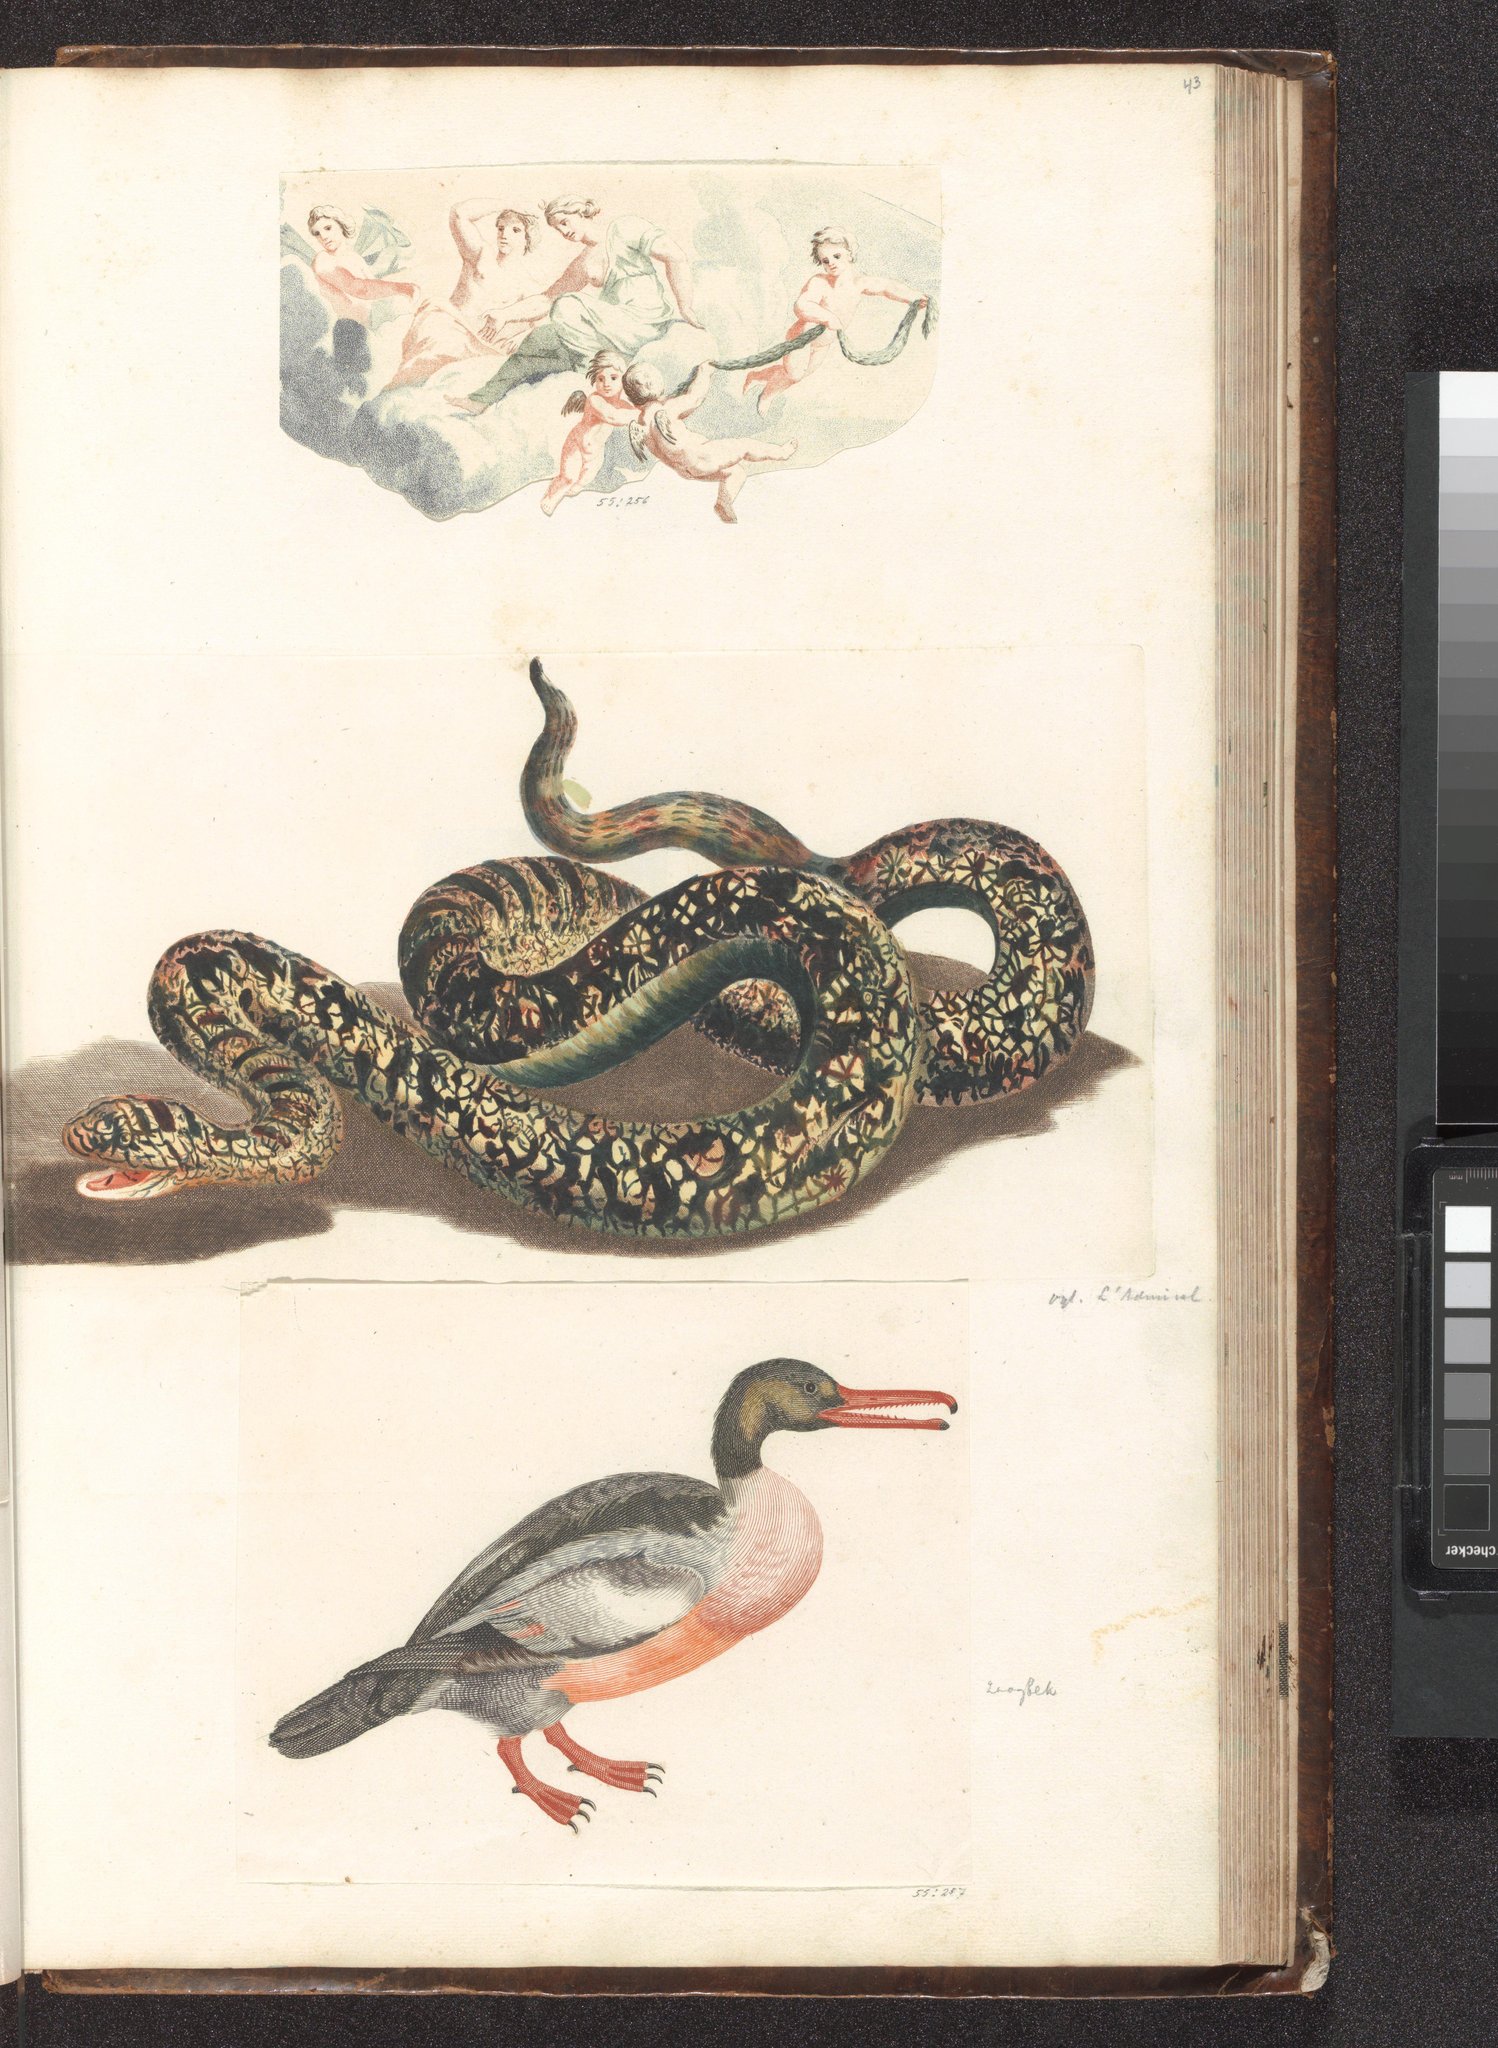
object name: album leaf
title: Slang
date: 1688-1698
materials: paper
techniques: printing, engraving, hand coloring, lithography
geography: netherlands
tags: snakes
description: Gekronkelde slang met open bek. Deze prent maakt deel uit van een album.